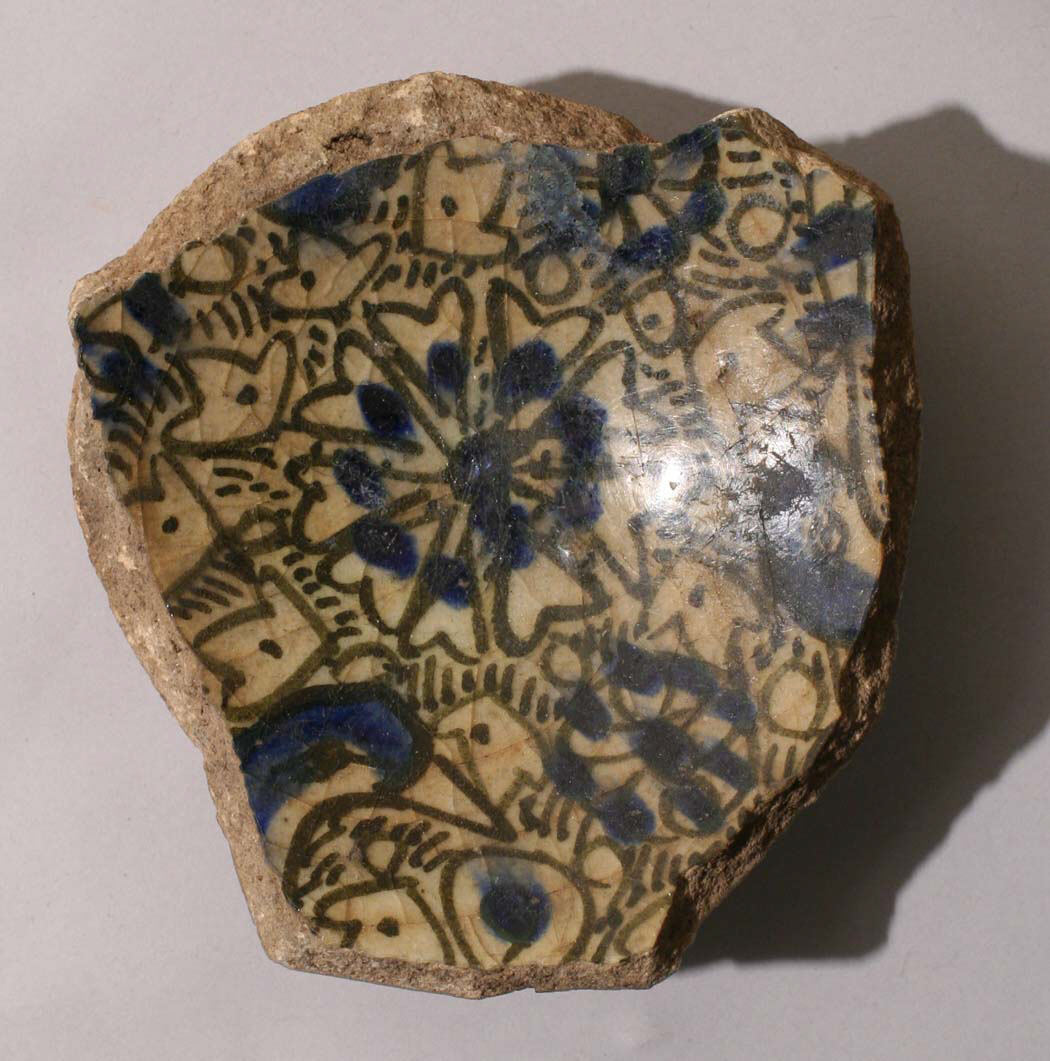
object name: fragment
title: Ceramic Fragment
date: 1301-1400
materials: stonepaste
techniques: painting, underglaze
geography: syria